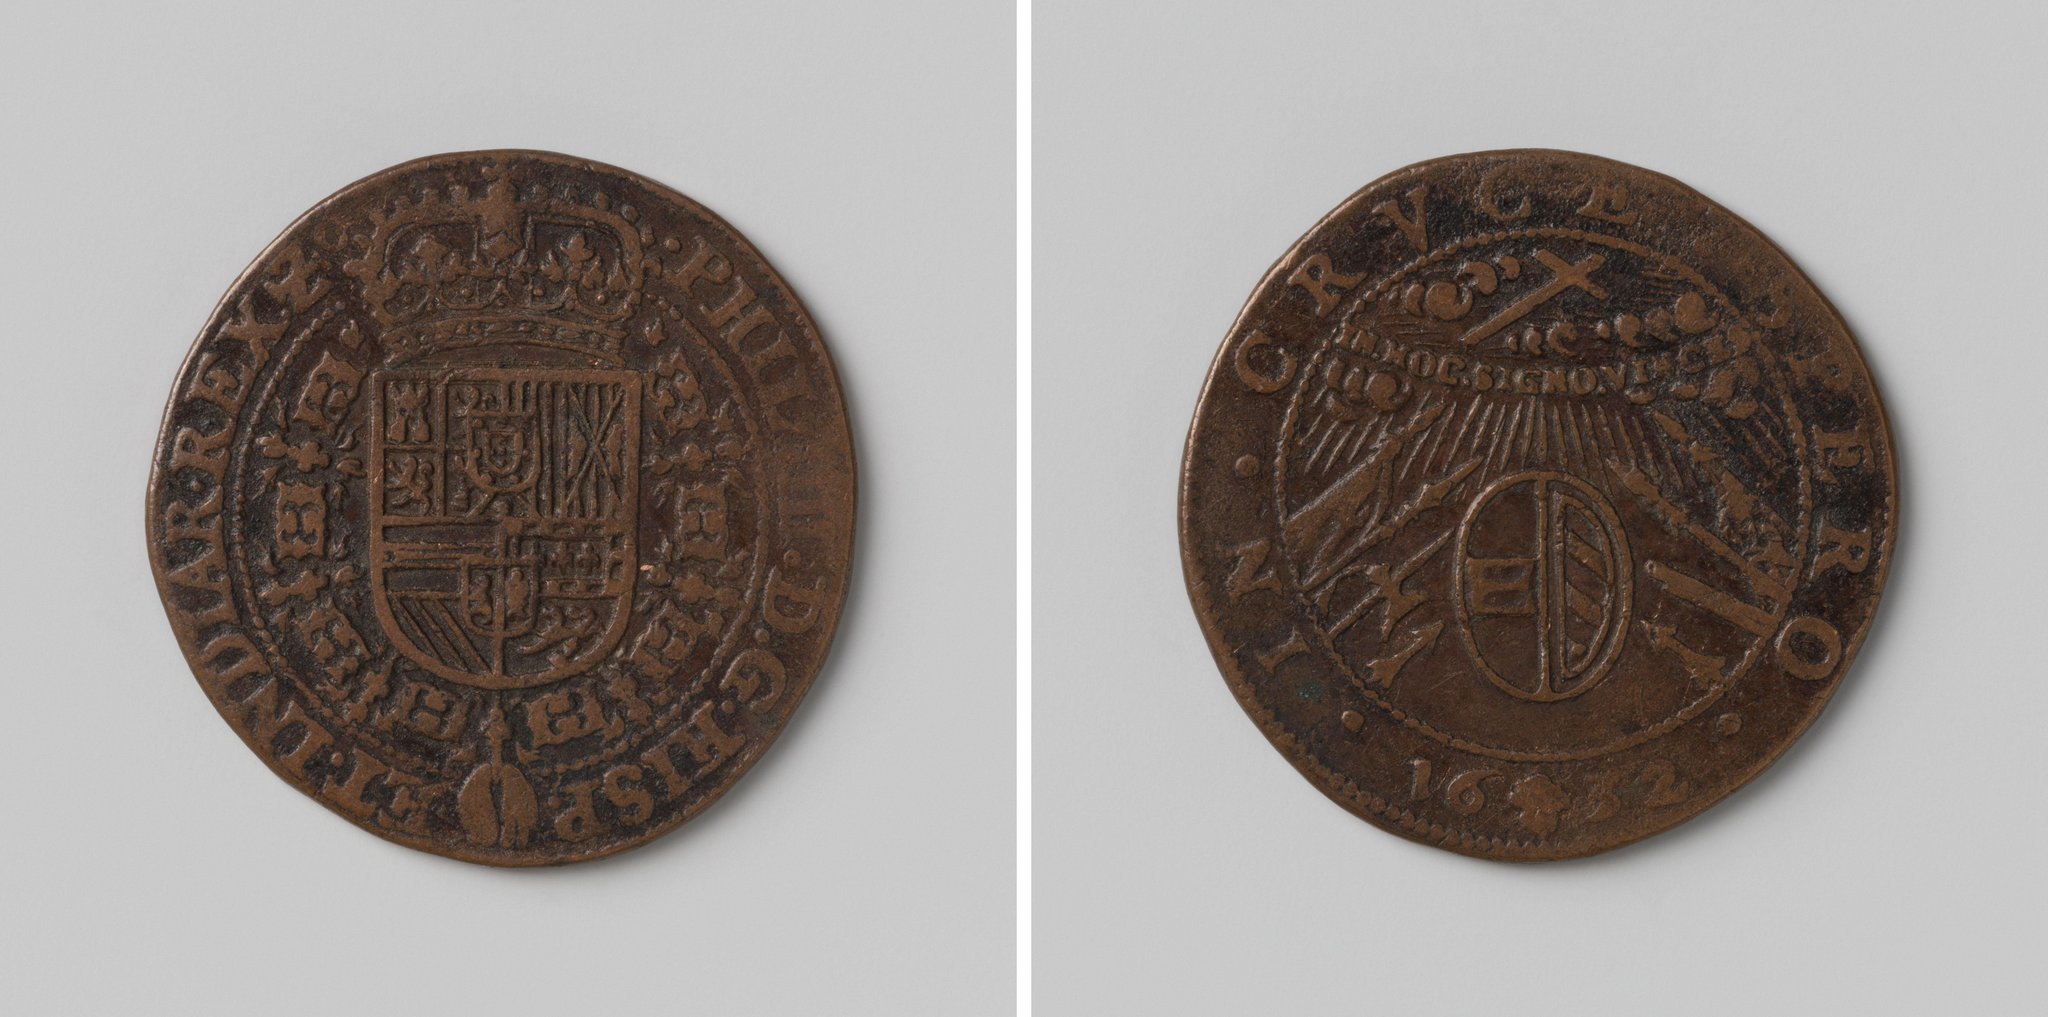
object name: jeton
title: Vertrouwen op God, rekenpenning ter ere van Filips IV, koning van Spanje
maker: Anonymous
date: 1632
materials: copper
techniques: striking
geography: brussels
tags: filips iv (koning van spanje)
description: Koperen penning. Voorzijde: gekroond wapenschild, omhangen met de orde van het Gulden Vlies binnen omschrift. Keerzijde: wapenschild, omgeven door wapentuig; daarboven: stralend kruis in wolken boven opschrift binnen omschrift